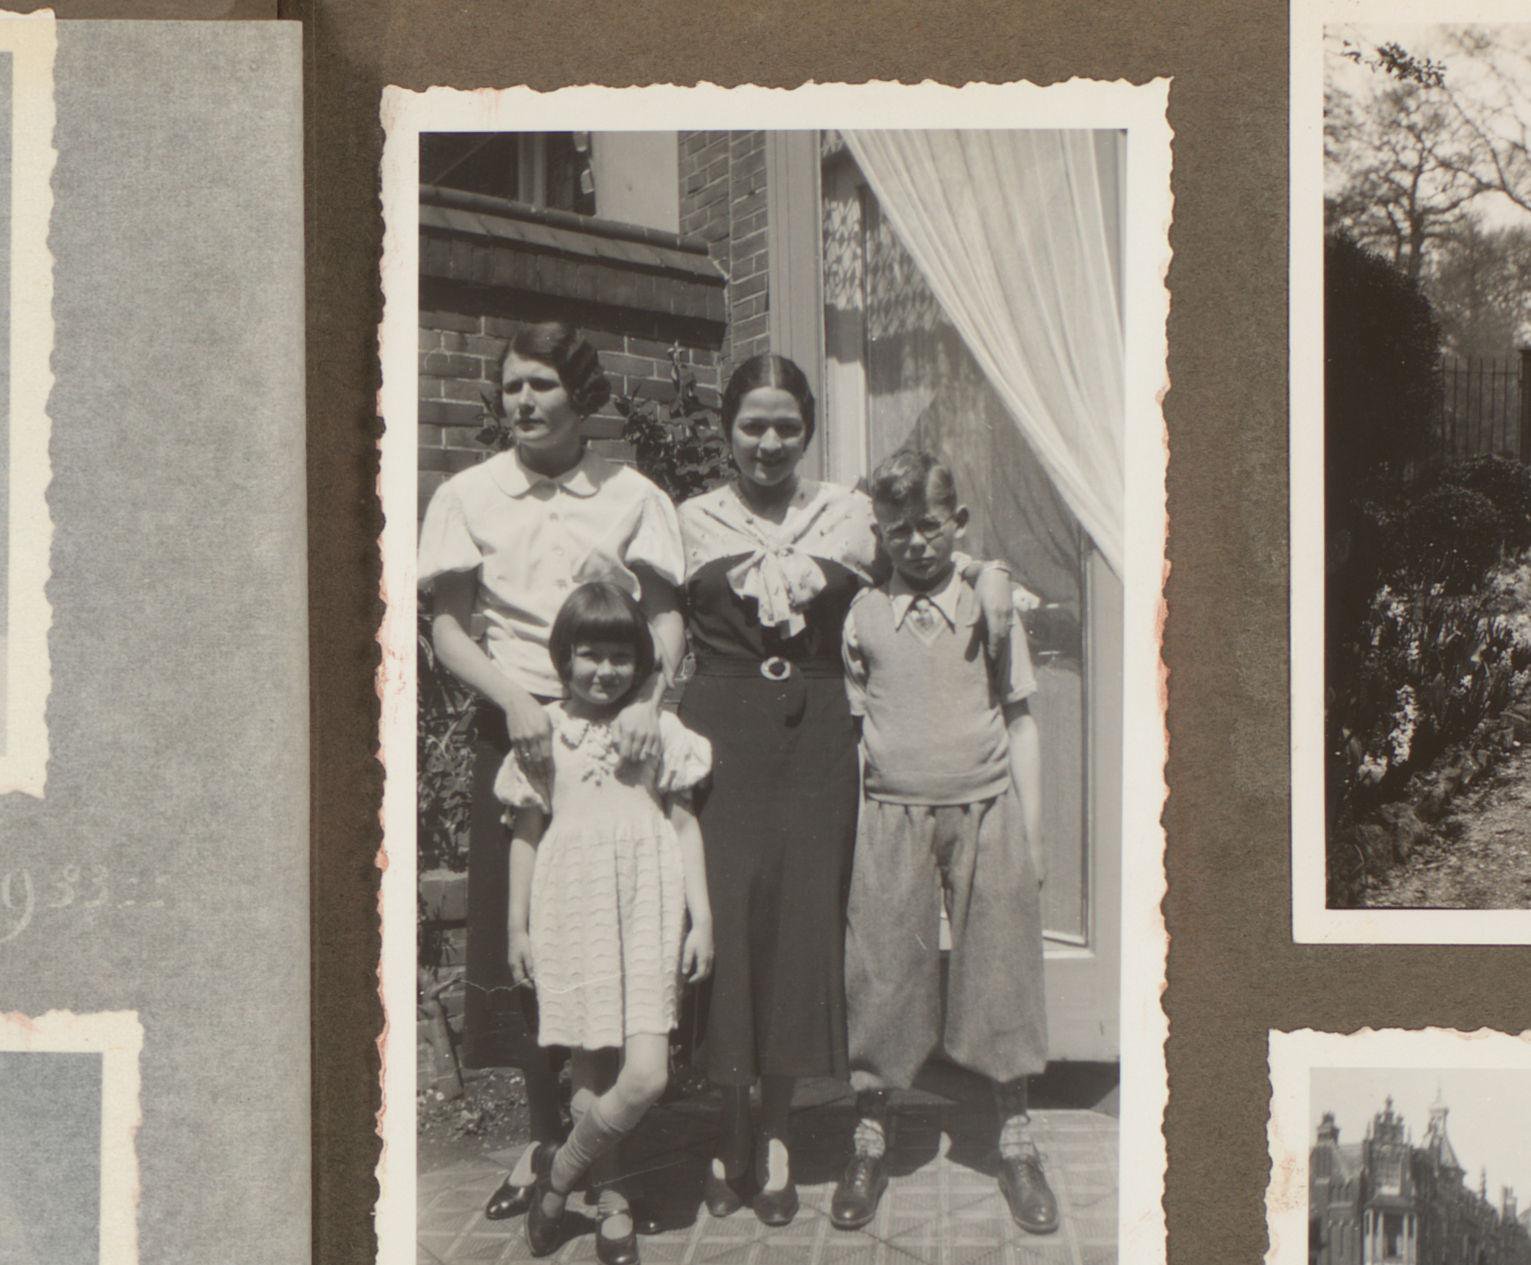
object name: album leaf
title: Groepsportret van Annie Bennink met haar kinderen en een vrouw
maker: Anonymous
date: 1933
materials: paper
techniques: gelatin silver print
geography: the hague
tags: historical persons not known by name - bb - woman, mother and child(ren), woman and child(ren) (family group)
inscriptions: inscription: ‘Annie Bennink/ +/ kinderen’